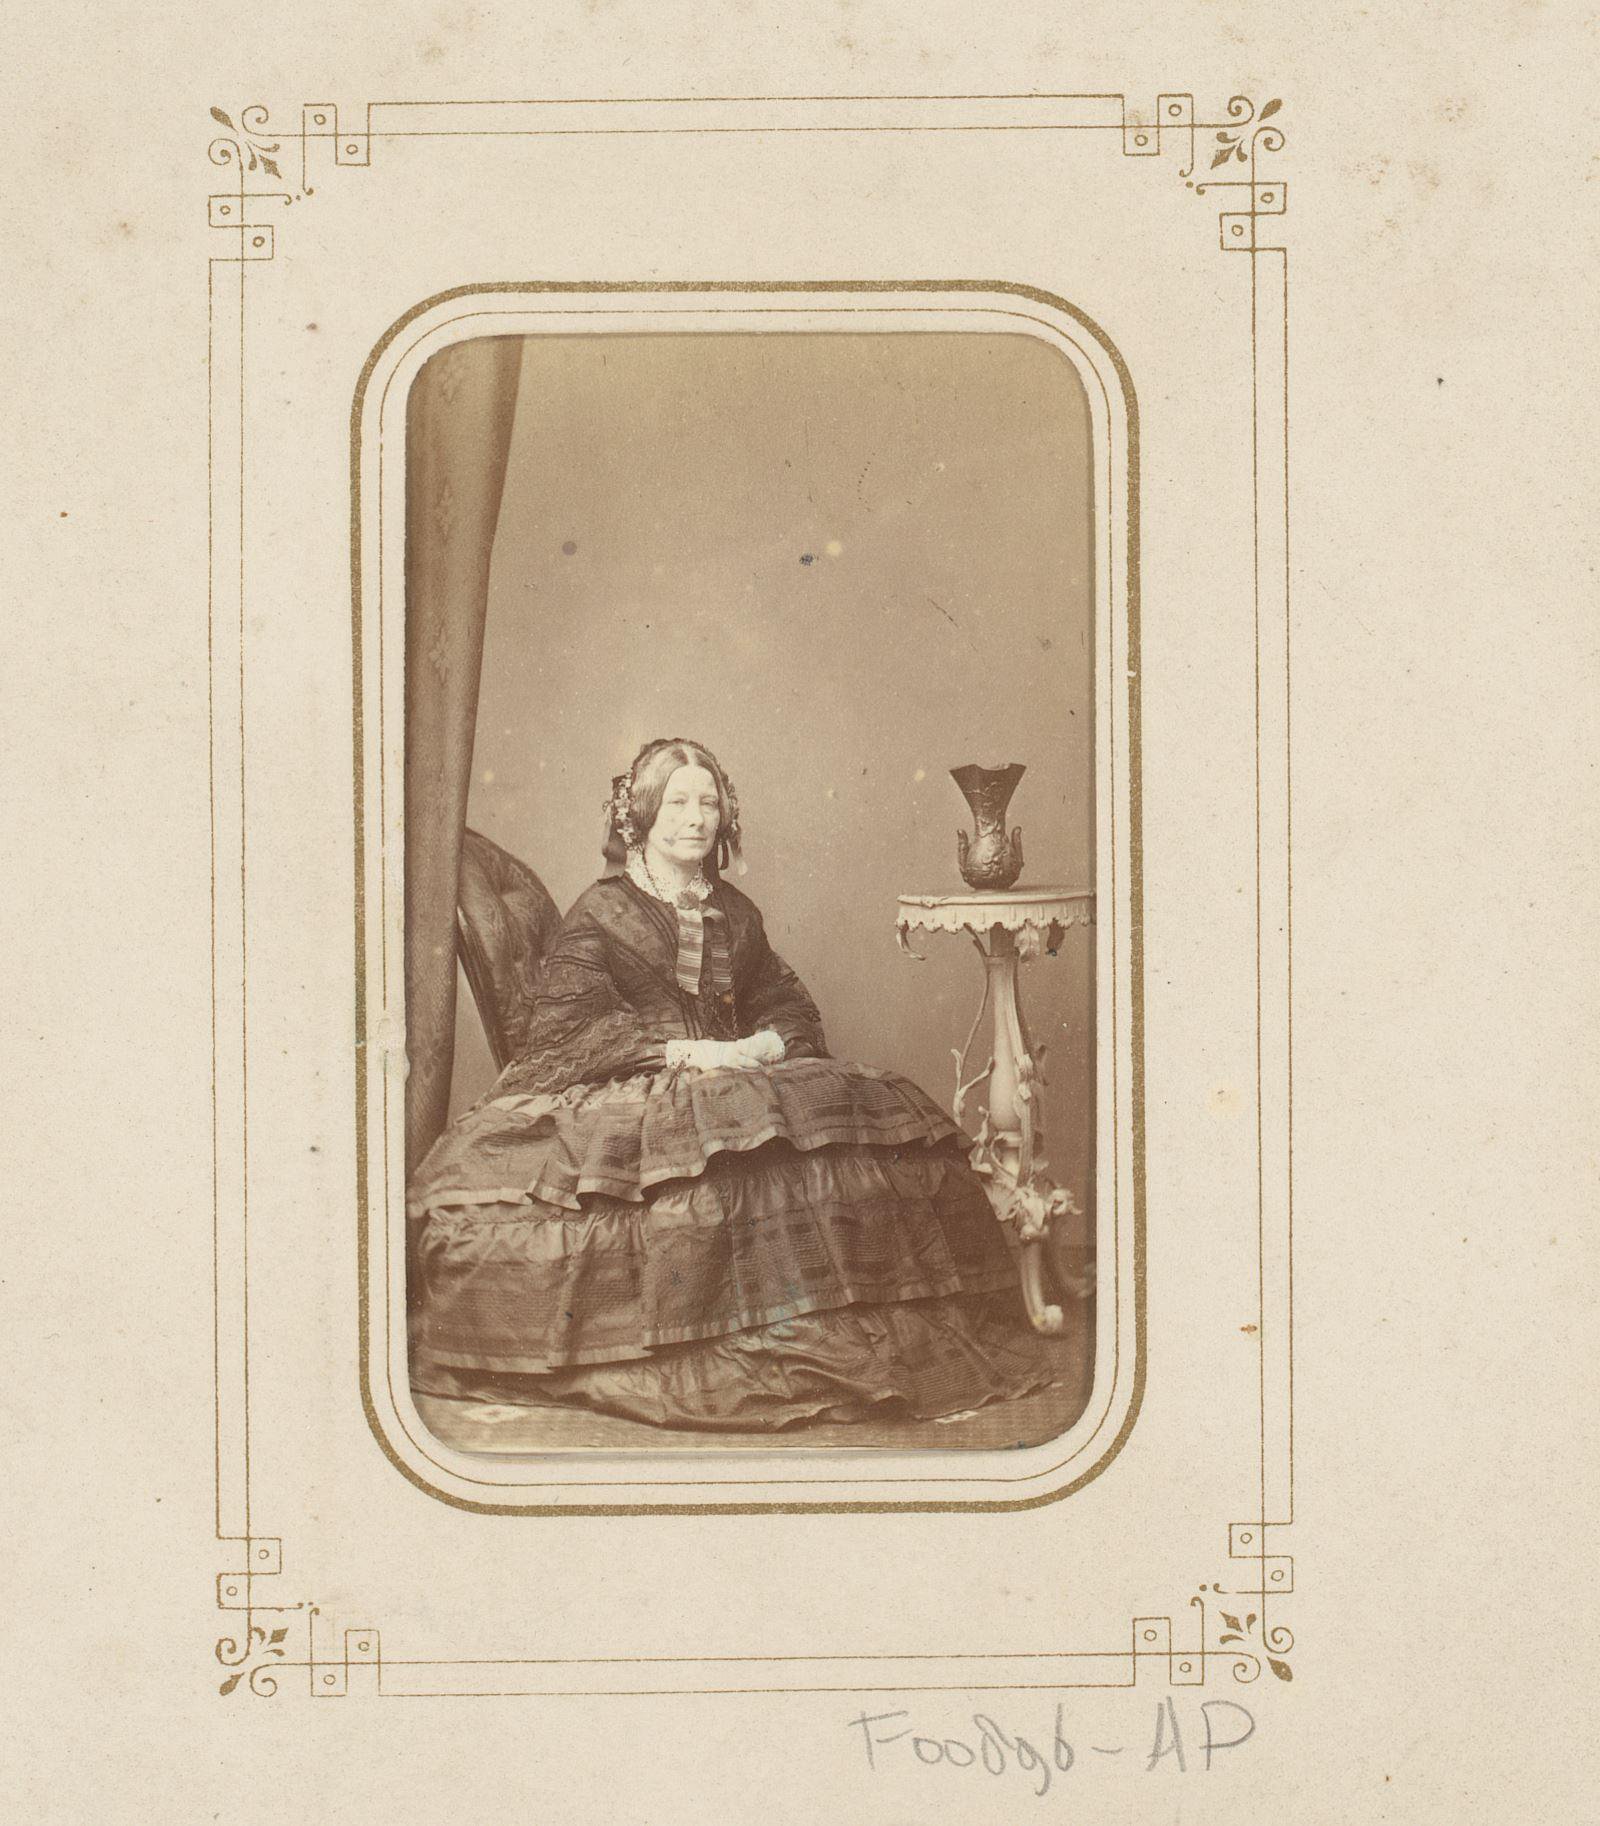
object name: album leaf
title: Portret van een vrouw, zittend bij een tafel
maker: william elliot debenham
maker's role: fotograaf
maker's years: 1839-1924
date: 1861-1865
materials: cardboard, photographic support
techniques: albumen print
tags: sitting figure - aa - female human figure, historical persons, table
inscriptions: number: ‘1977’, inscription: ‘W. E. Debenham/ 158, Regent Street/ W.’